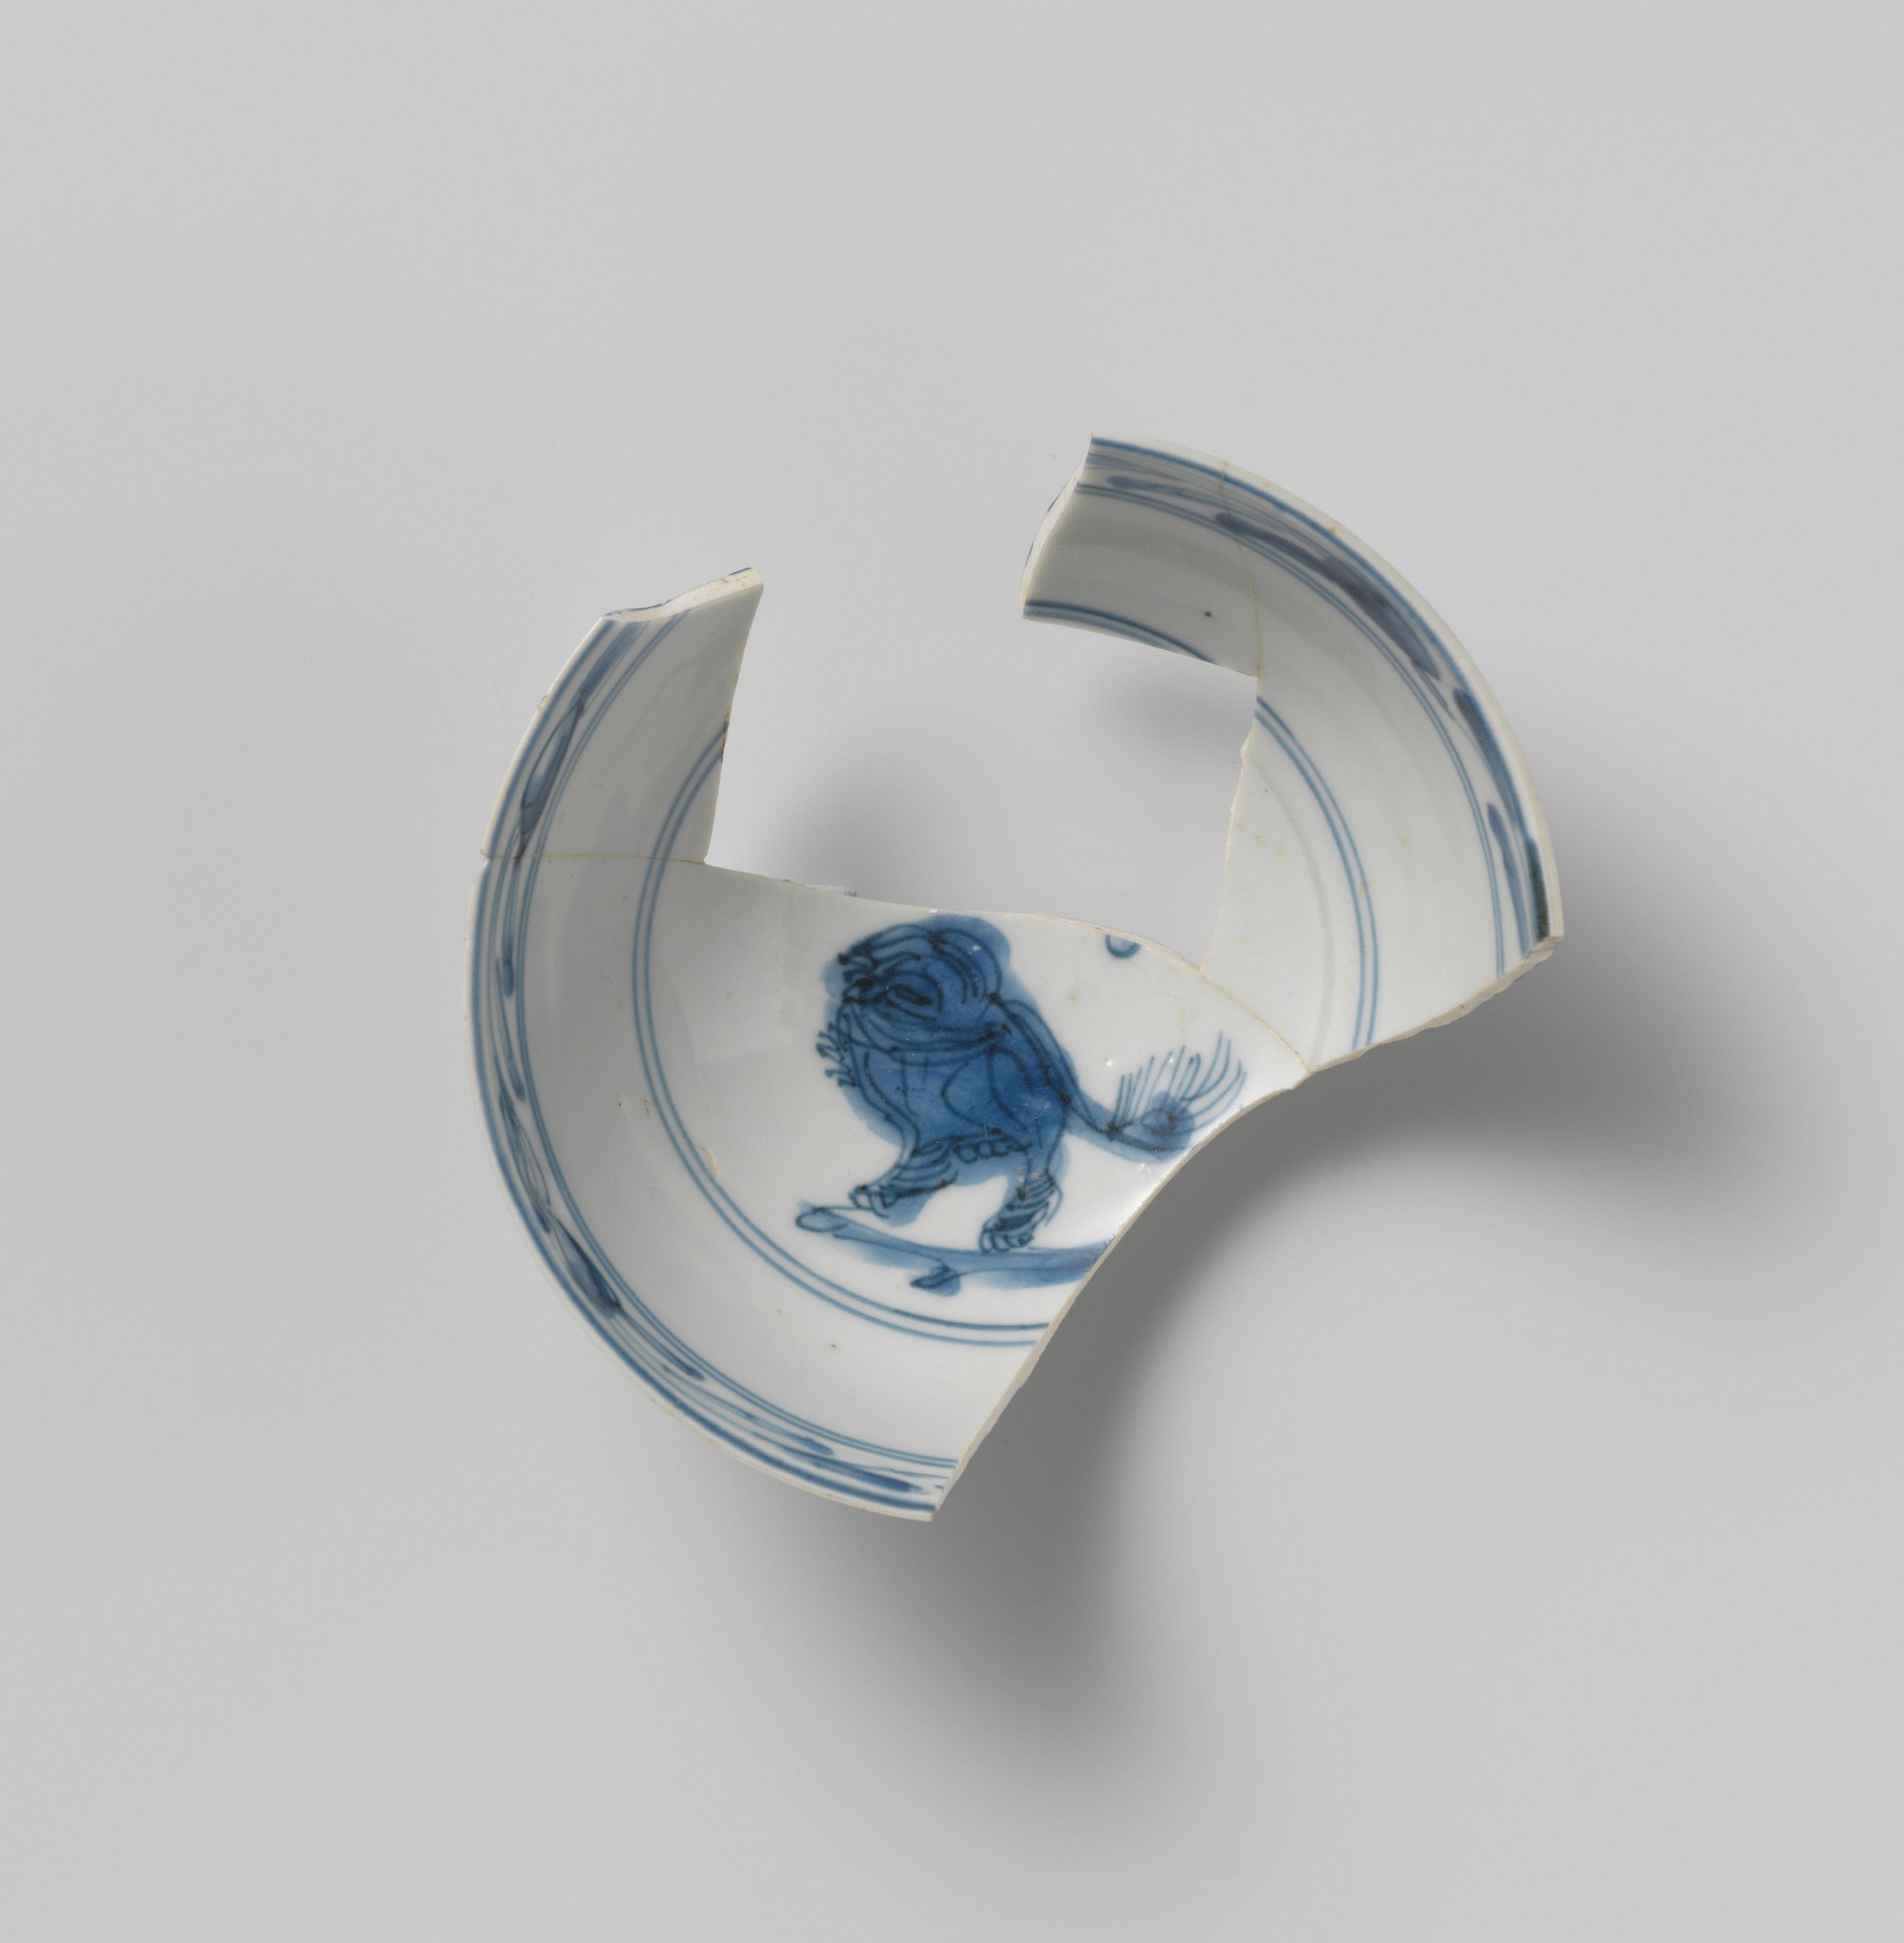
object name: bowl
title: Fragment kom uit V.O.C.-schip de 'Witte Leeuw'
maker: Anonymous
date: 1613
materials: porcelain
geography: jingdezhen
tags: verenigde oostindische compagnie, sint-helena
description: A bowl. A central decoration of a lion dog (fu) encircled by a band of lotus panels.